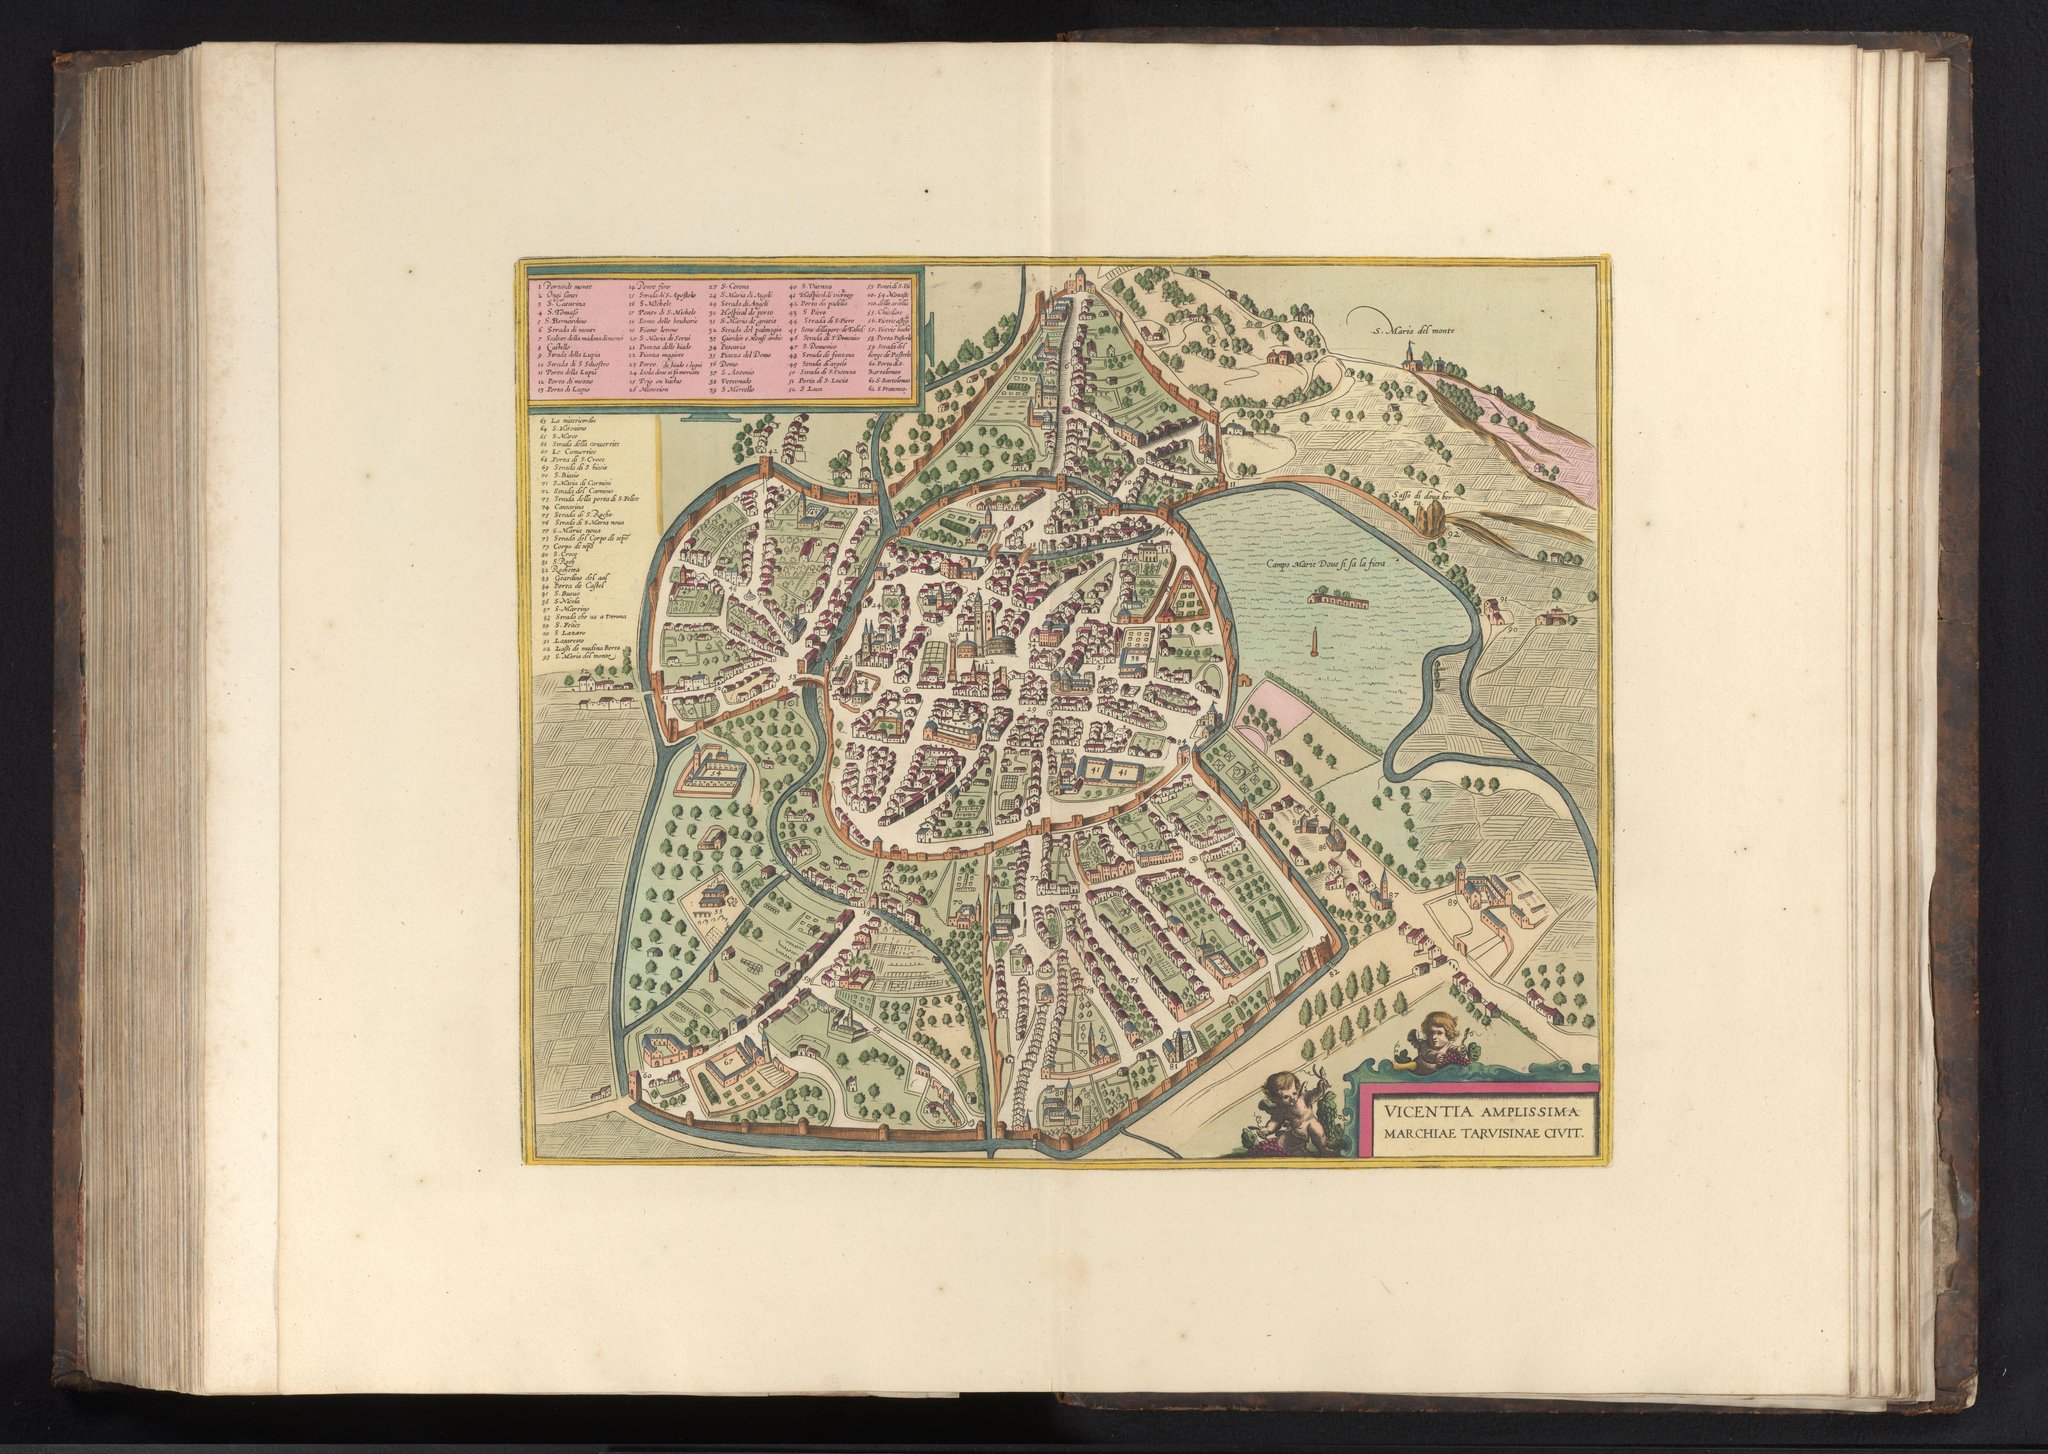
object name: album leaf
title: Vicentia amplissima marchiae tarvisnae civit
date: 1600-1699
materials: paper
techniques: colour, etching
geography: the hague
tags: bird's eye view ~ architectural design or model, maps of cities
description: Gezicht op Vicenza in vogelvluchtperspectief. Rechtsonder een cartouche met titel en twee putti. Linksboven een verklarende lijst met nummers. Prent maakt deel uit van een album.